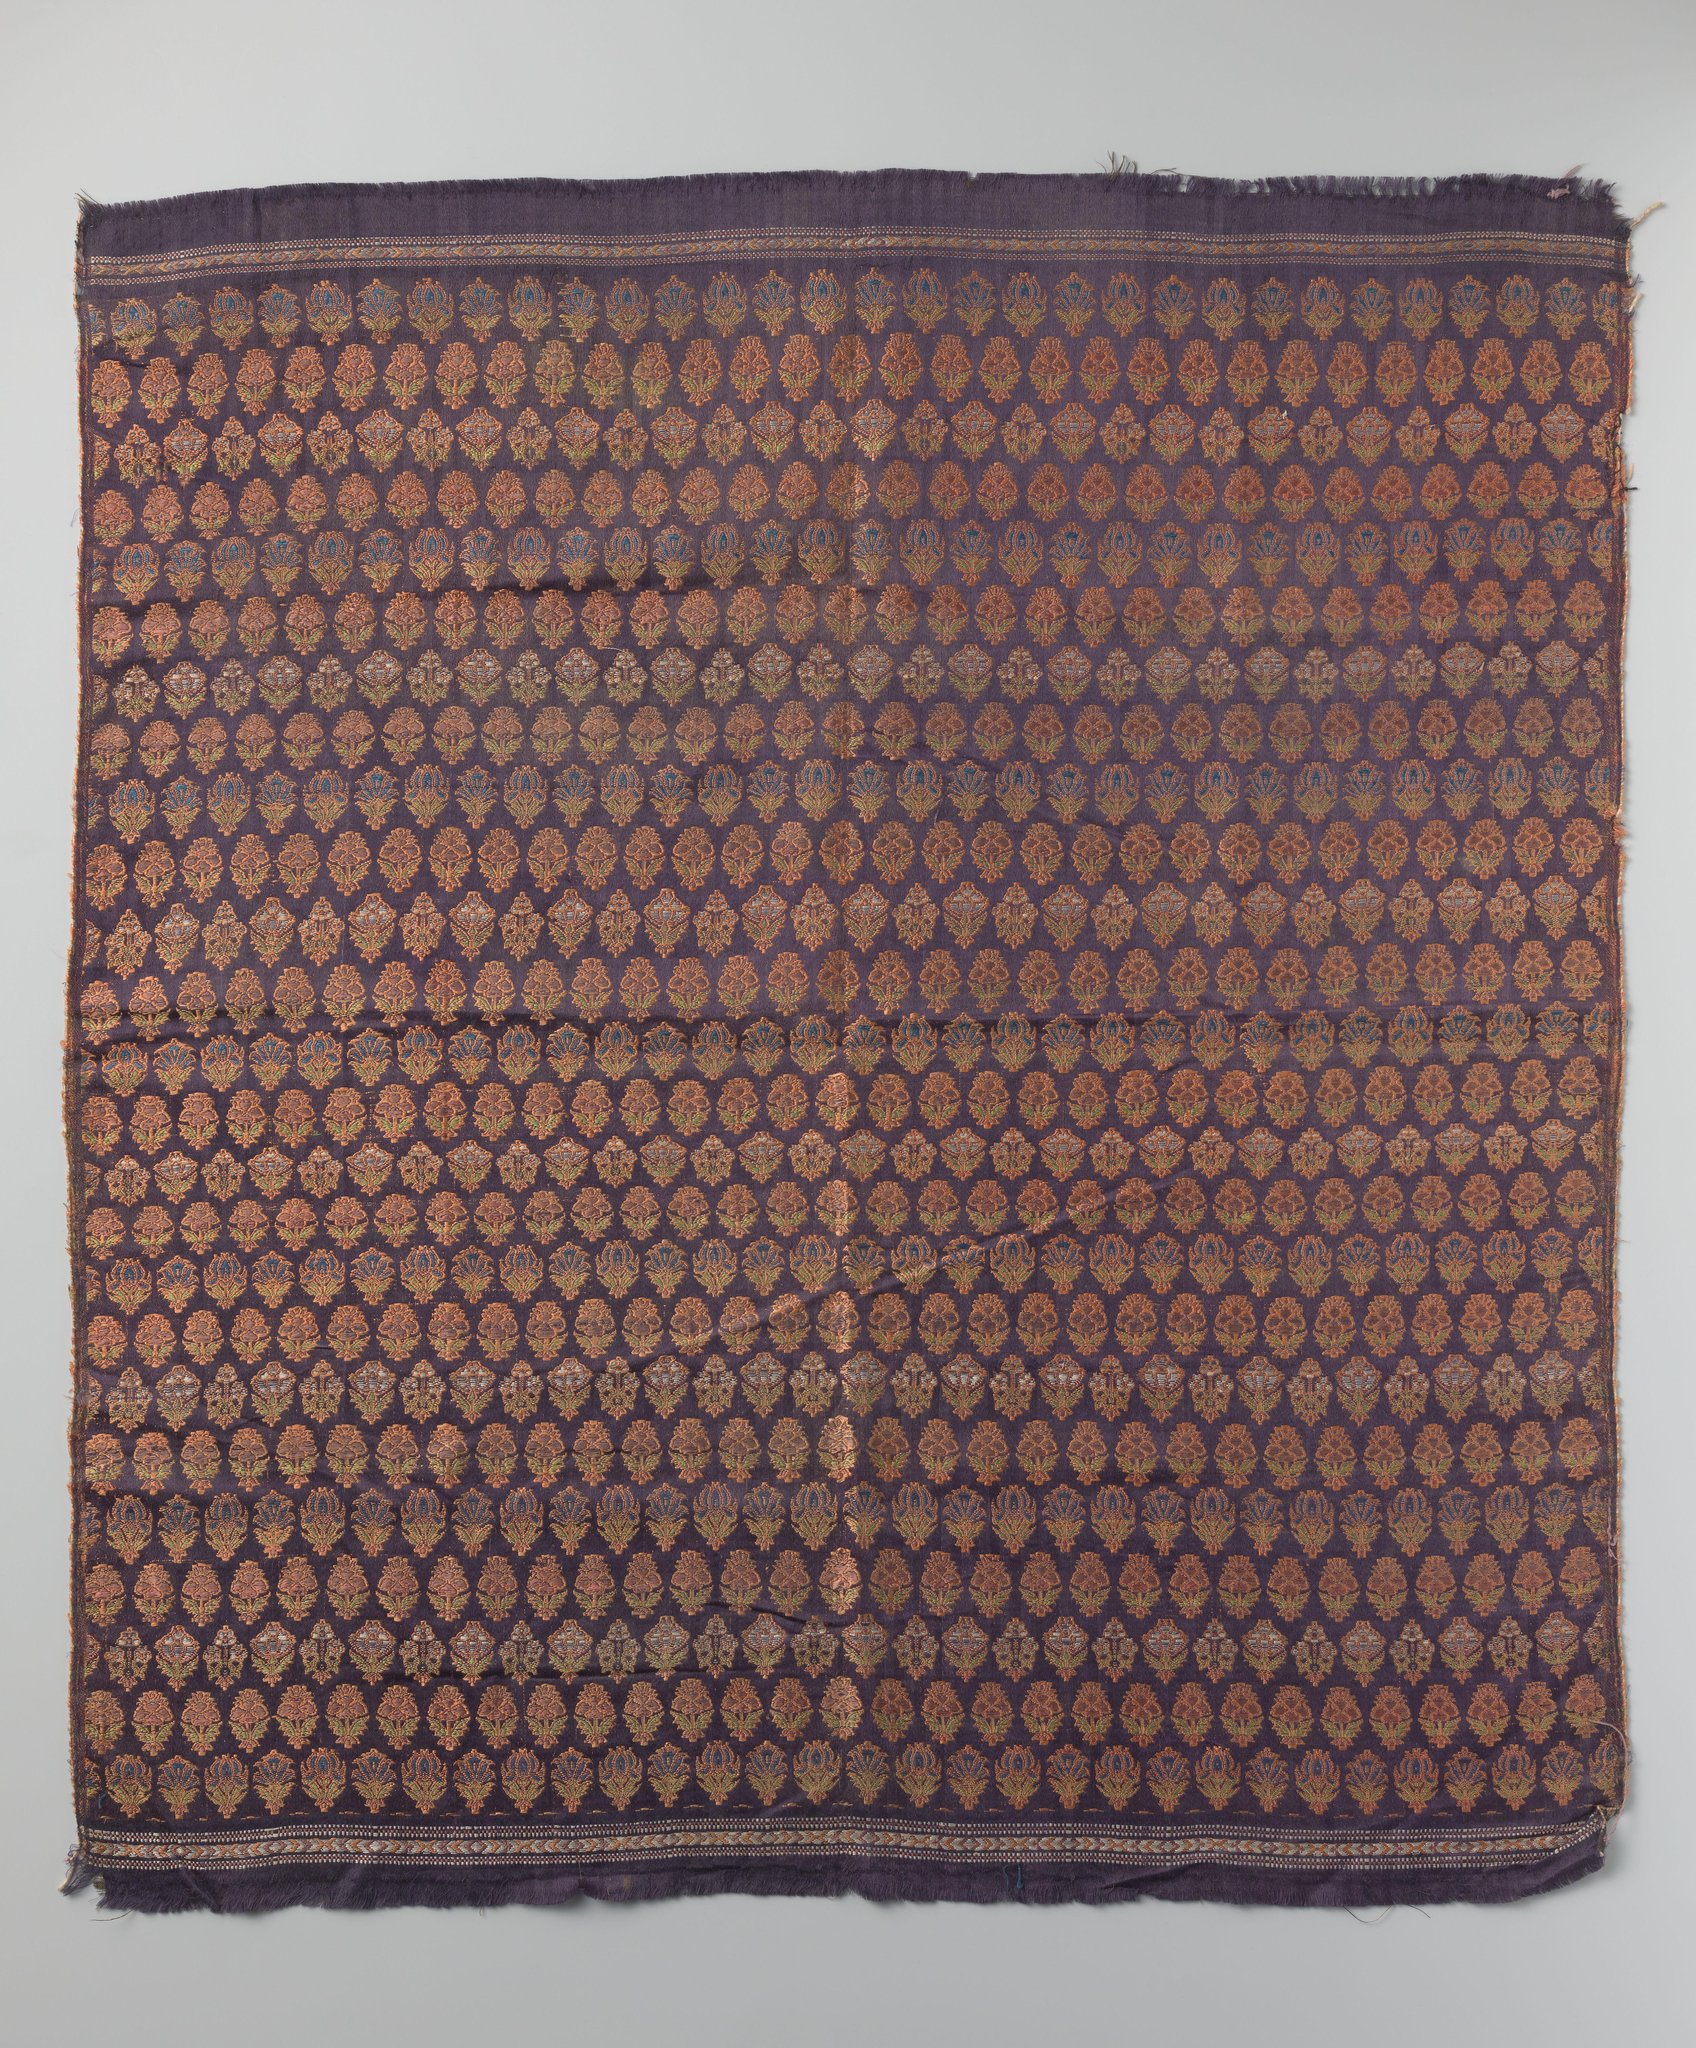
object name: kleed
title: Kleed van zijde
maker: Anonymous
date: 1800-1899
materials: linen, silk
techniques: lampas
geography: iran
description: Zijden kleedje. Drie rijen symmetrische bloemtakken herhalen zich regelmatig tussen twee rijen palmetten, waartussen een lichtblauwe kleur gegeven is op een paarsblauwe satijnen grond. Onder en boven een smalle rand met geometrische figuren. Oosterse textiel.